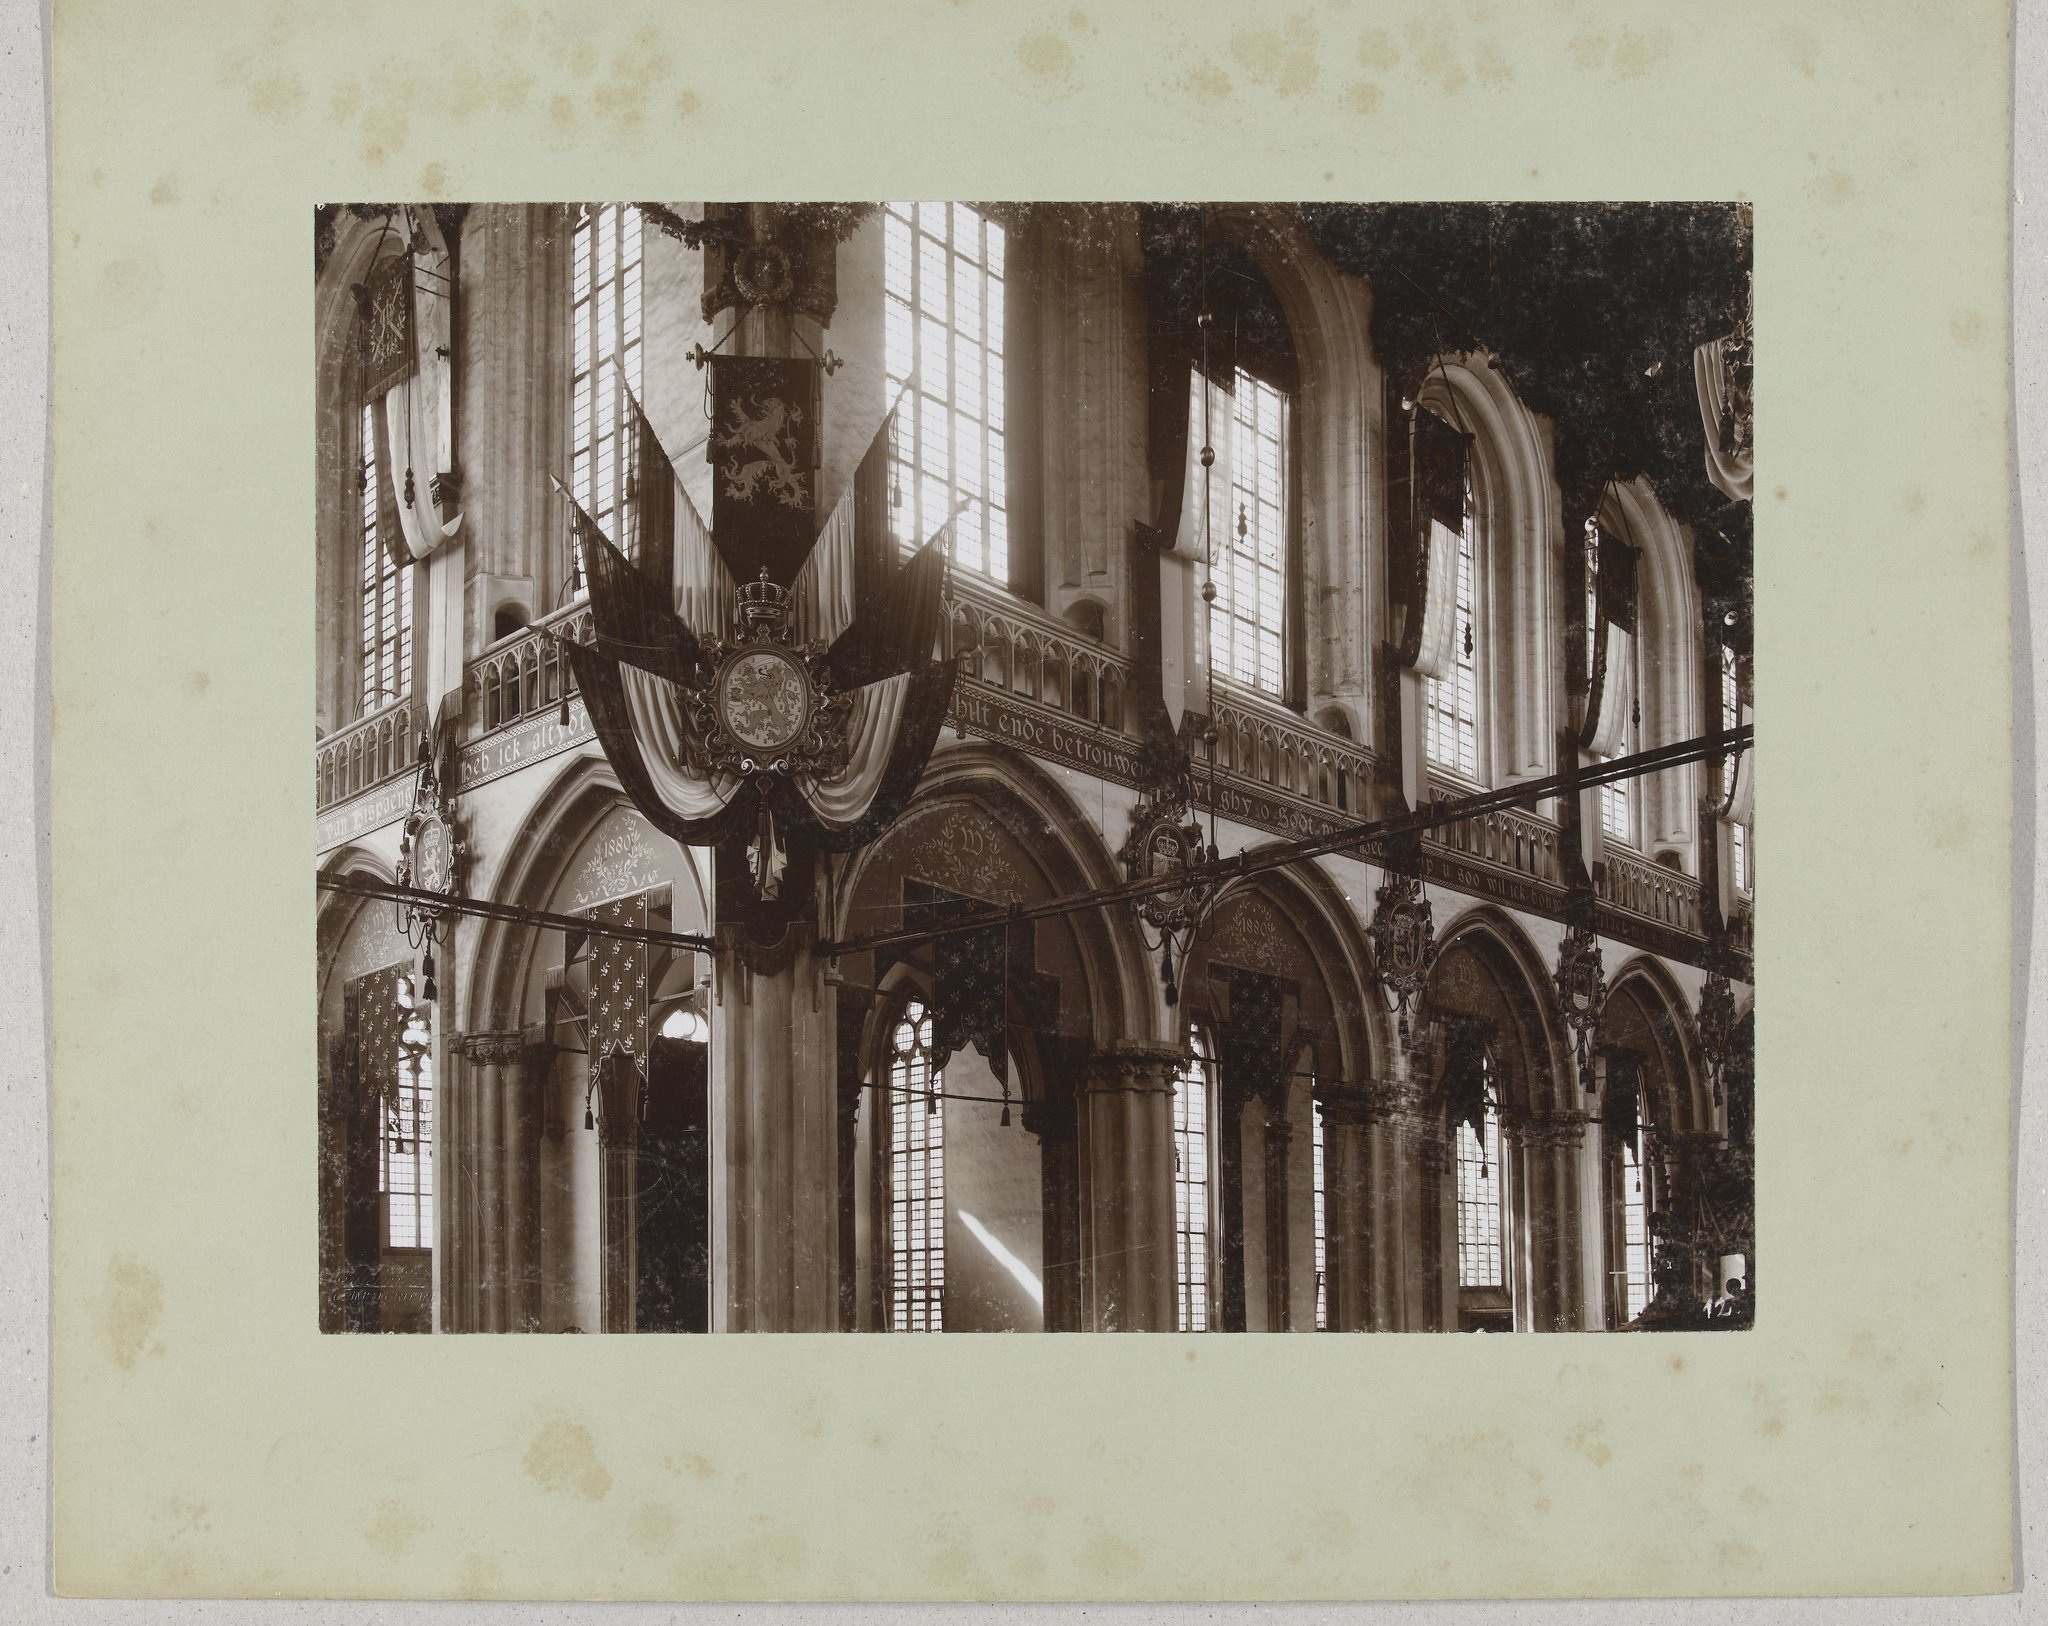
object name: photograph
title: Interieur van de Nieuwe Kerk, Amsterdam, zoals dat was bij de inhuldiging van Wilhelmina als koningin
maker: sigmund löw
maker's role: publisher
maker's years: 1845-1920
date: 1898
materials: paper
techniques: collodion silver print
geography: amsterdam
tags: the hague, wilhelmina of the netherlands, interior of church, amsterdam